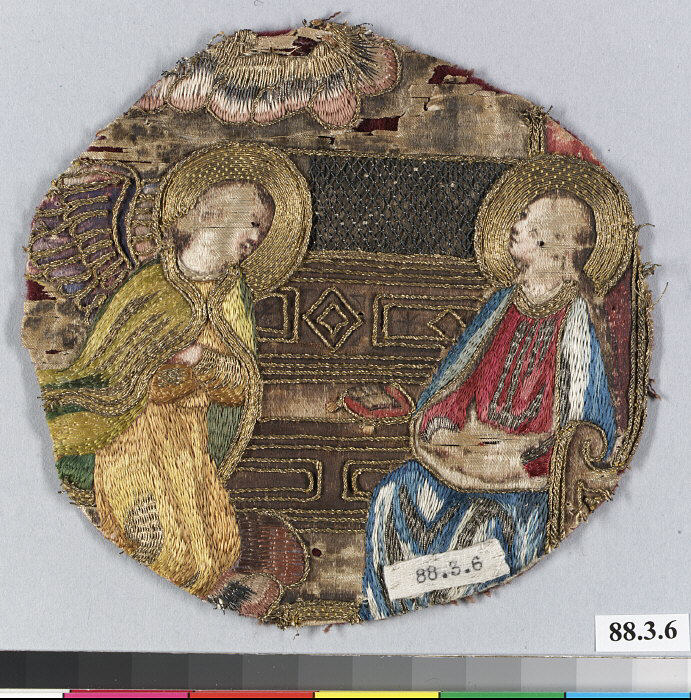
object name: panel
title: The Annunciation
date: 1501-1600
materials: metal thread, silk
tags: virgin mary,archangel gabriel,annunciation